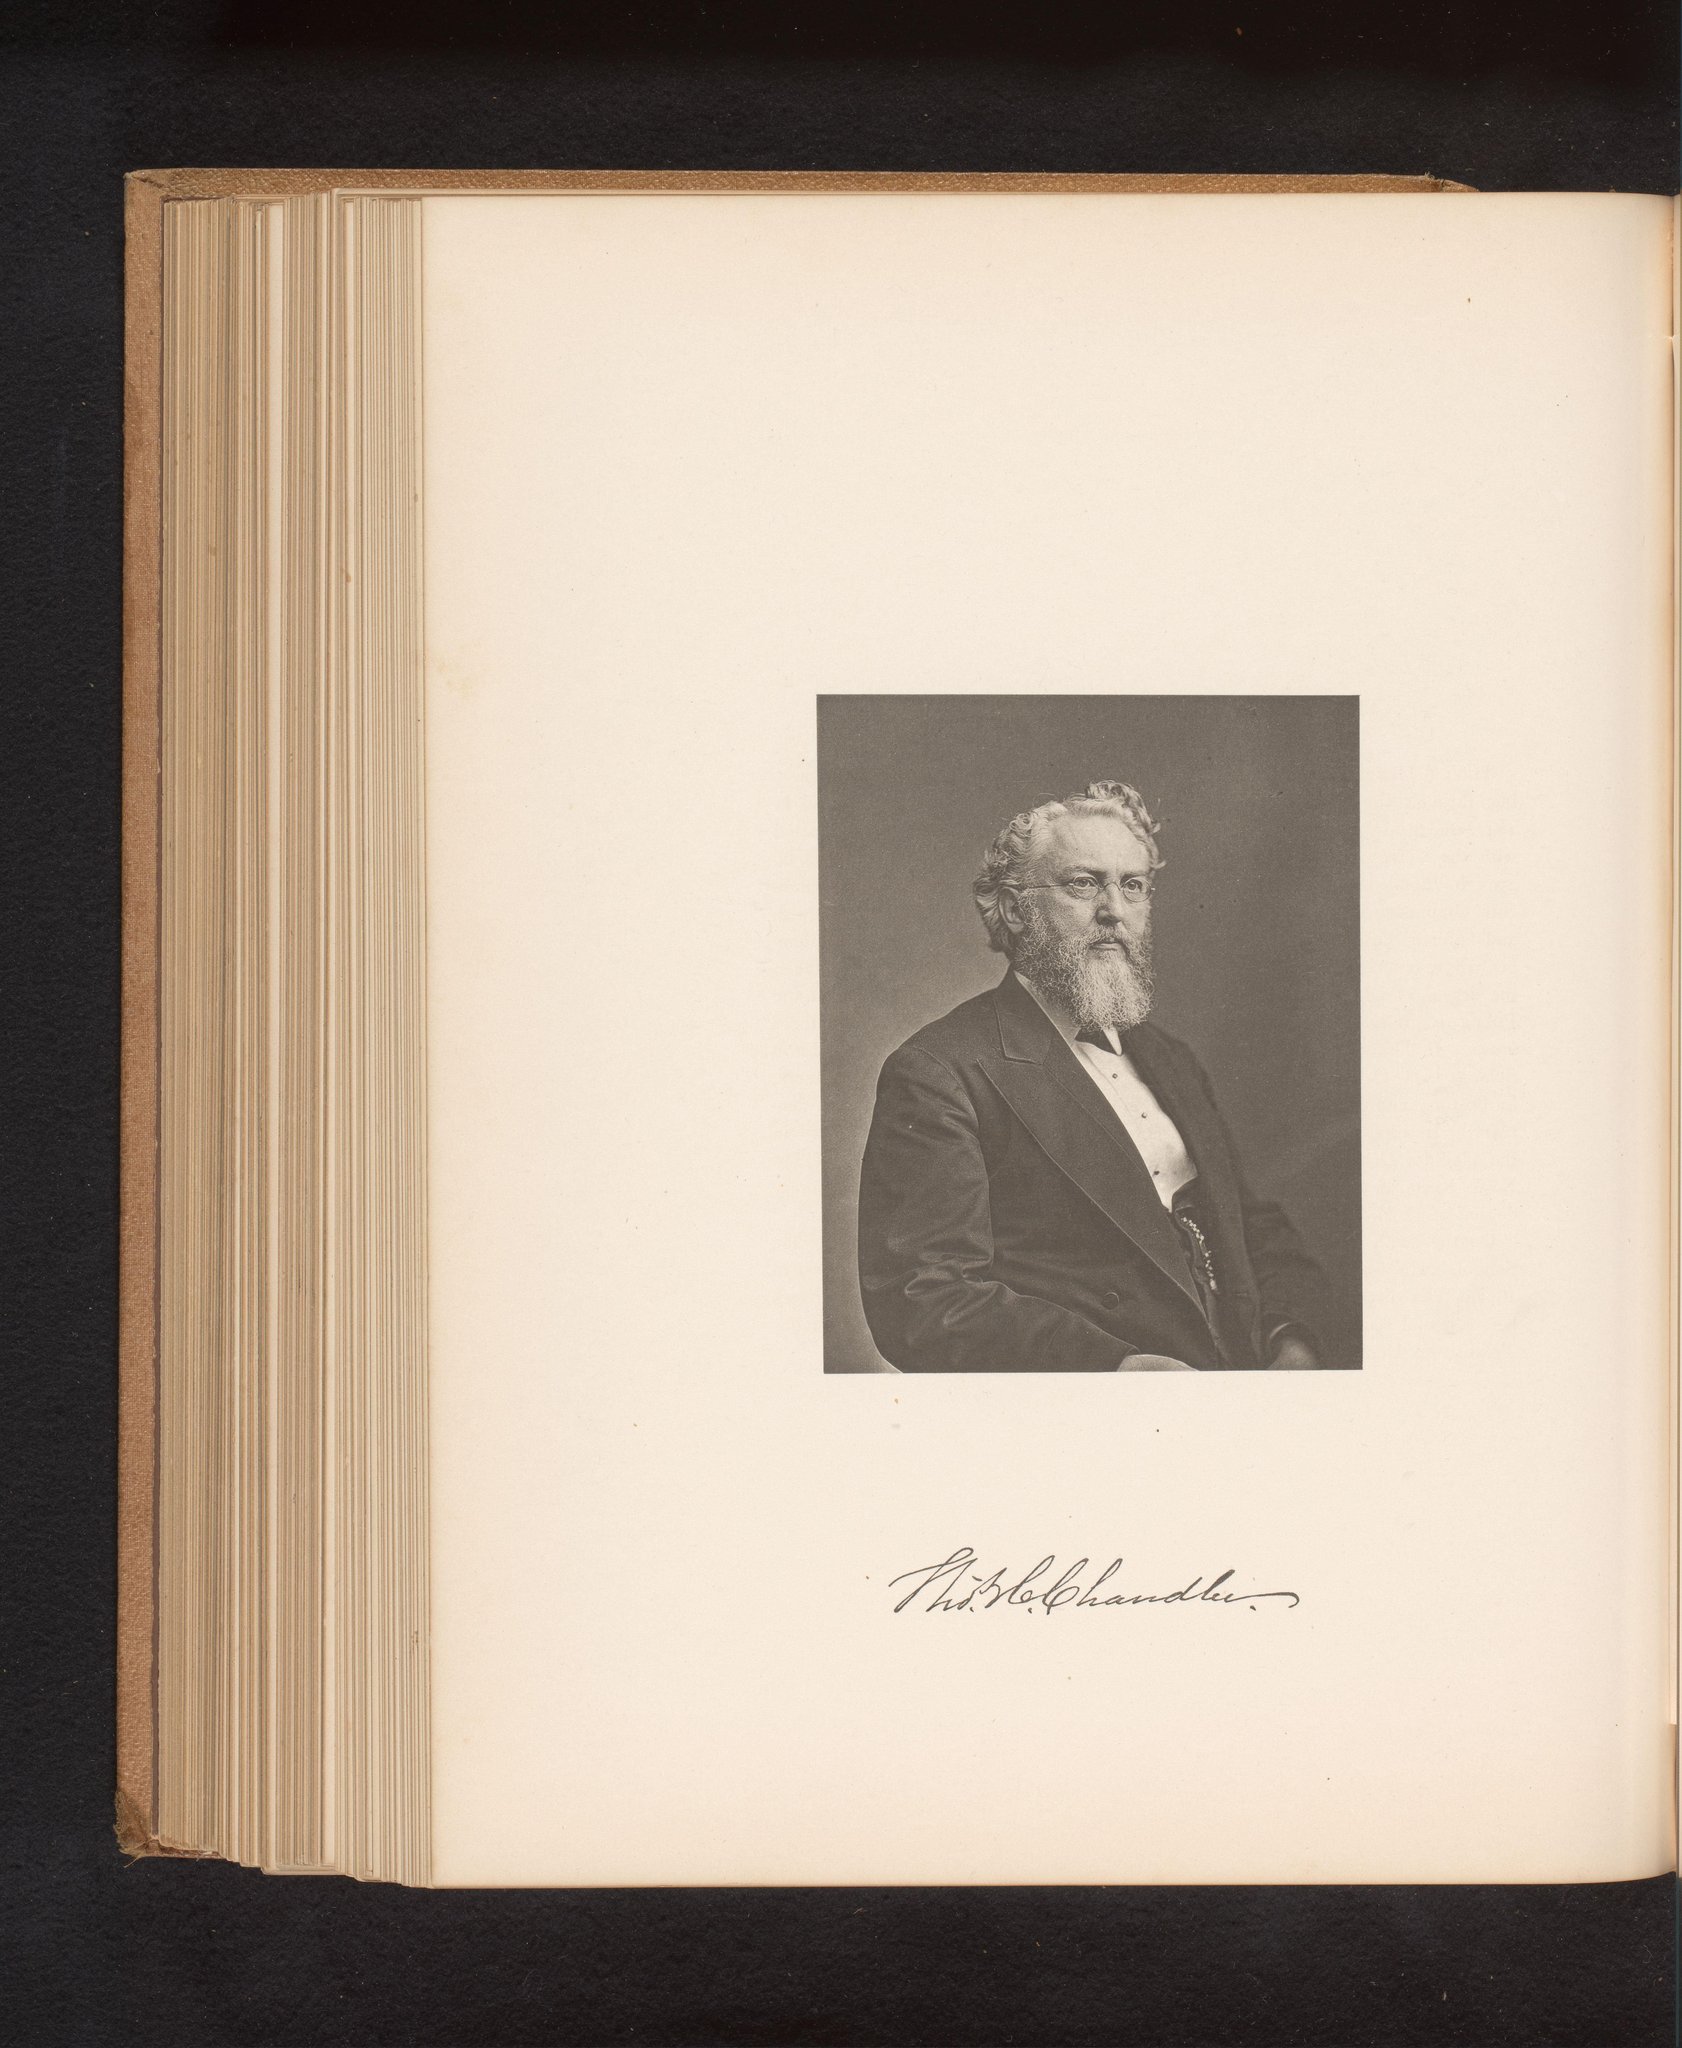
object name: page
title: Tho. Hen. Chandler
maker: Anonymous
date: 1870-1875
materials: paper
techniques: photograph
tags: (barber as) dentist (+ portrait of scholar, scientist), historical persons, professor